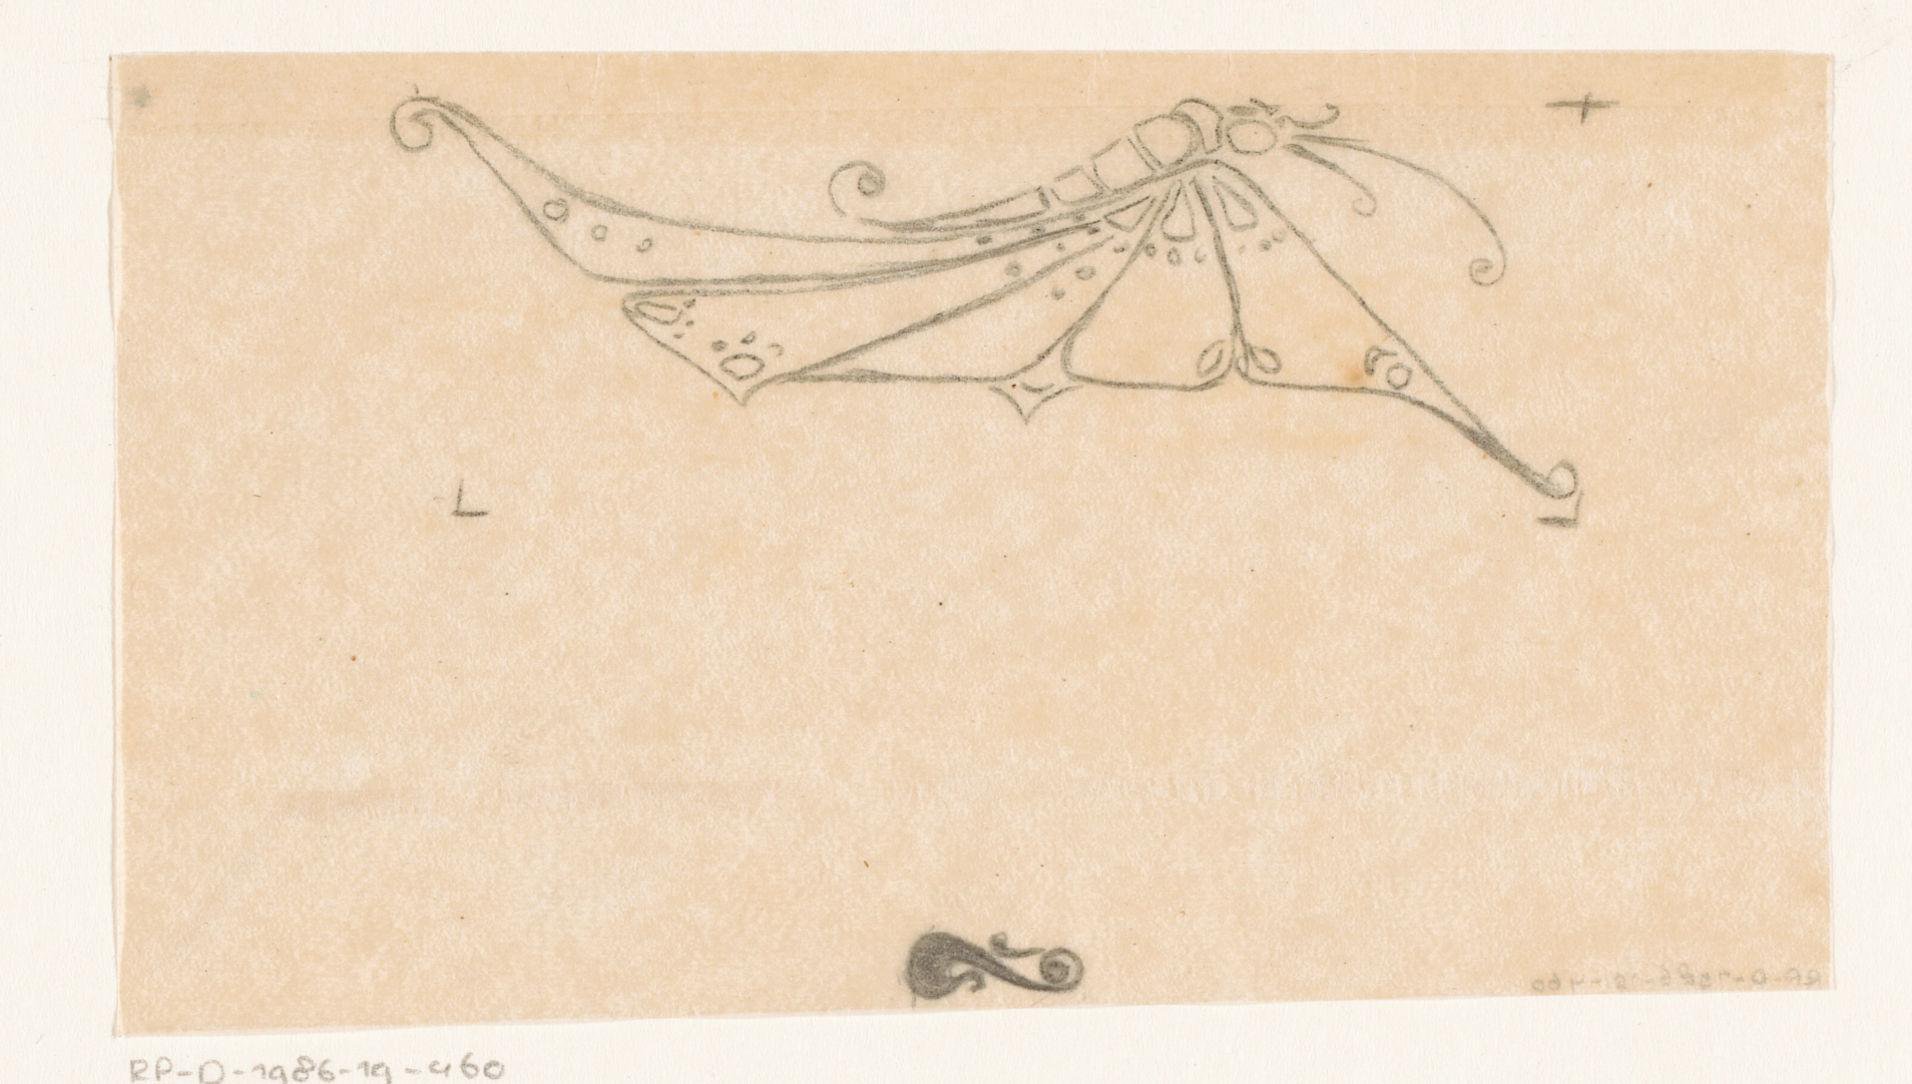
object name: study for binding design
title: Bandontwerp voor: W. Bölsche, Het wederzijdsche lokken, 1908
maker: reinier willem petrus de vries (1874-1953)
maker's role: draughtsman, print maker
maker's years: 1874-1953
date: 1908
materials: pencil, paper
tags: insects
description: Bandontwerp voor: Bölsche, Wilhelm. Het wederzijdsche lokken der beide geslachten in de liefde. Amsterdam: Meulenhoff, 1908.